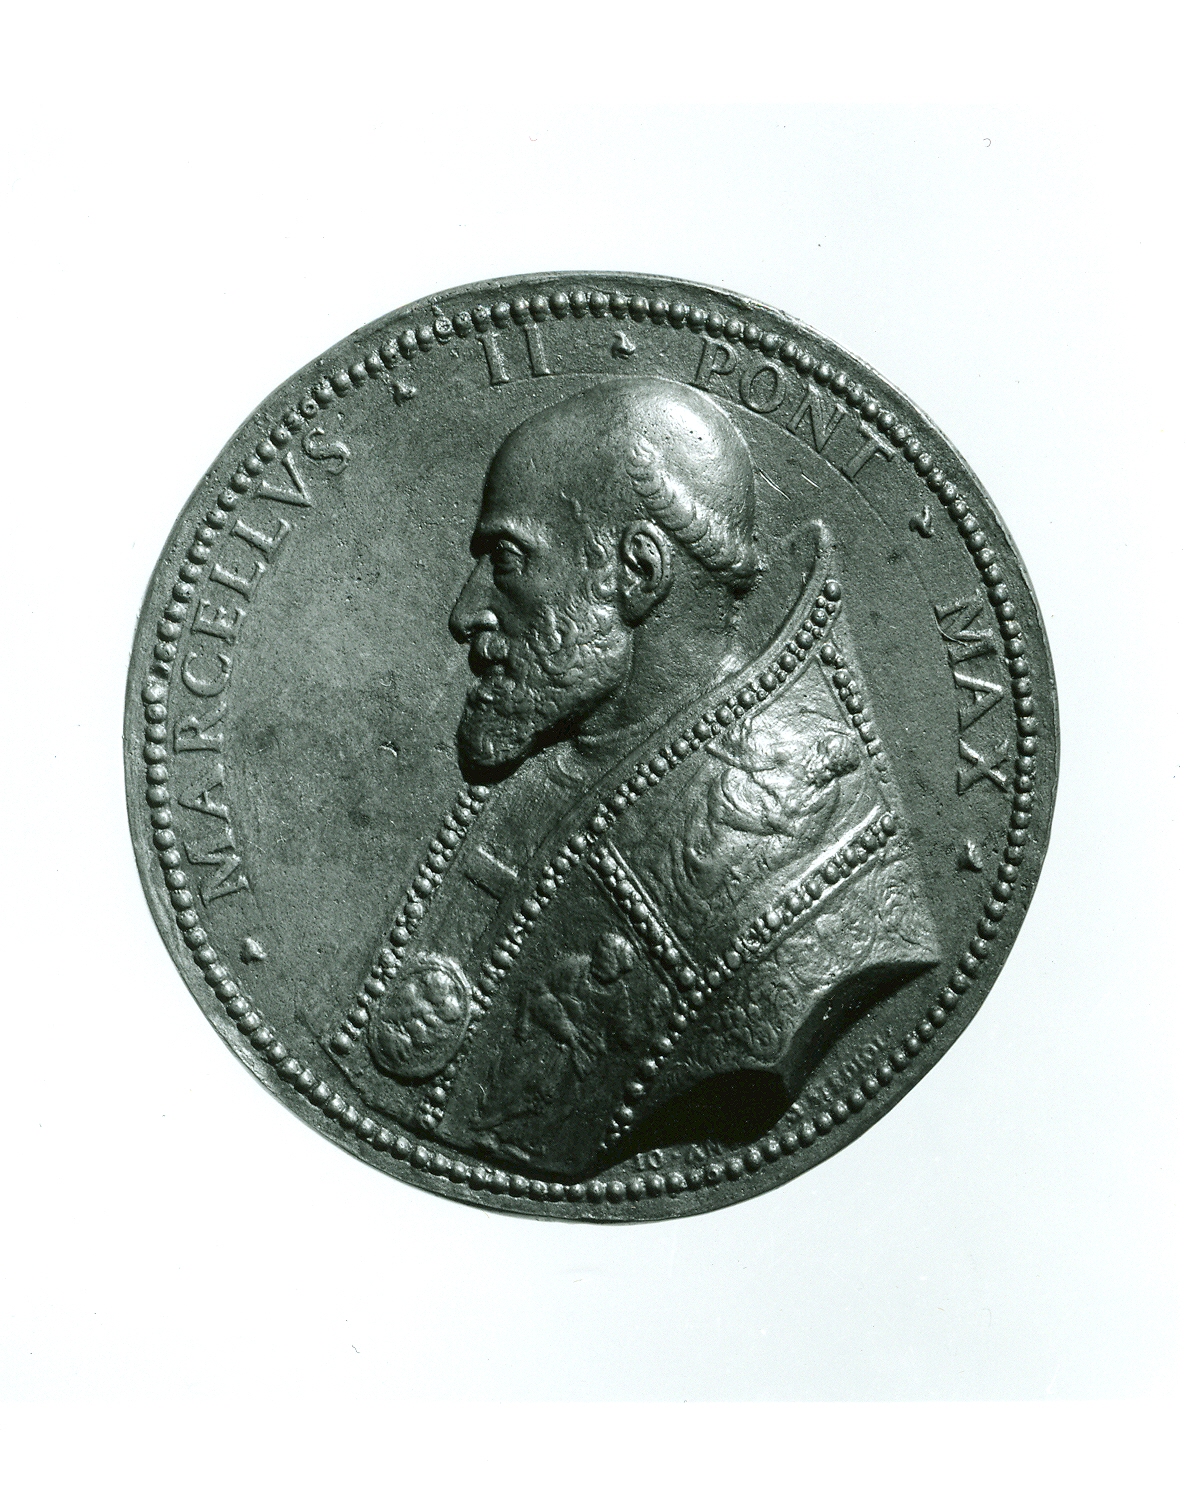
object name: medal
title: Medal: Pope Marcellus II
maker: giovanni antonio rossi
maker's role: artist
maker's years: 1517-1580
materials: bronze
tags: men,portraits,profiles